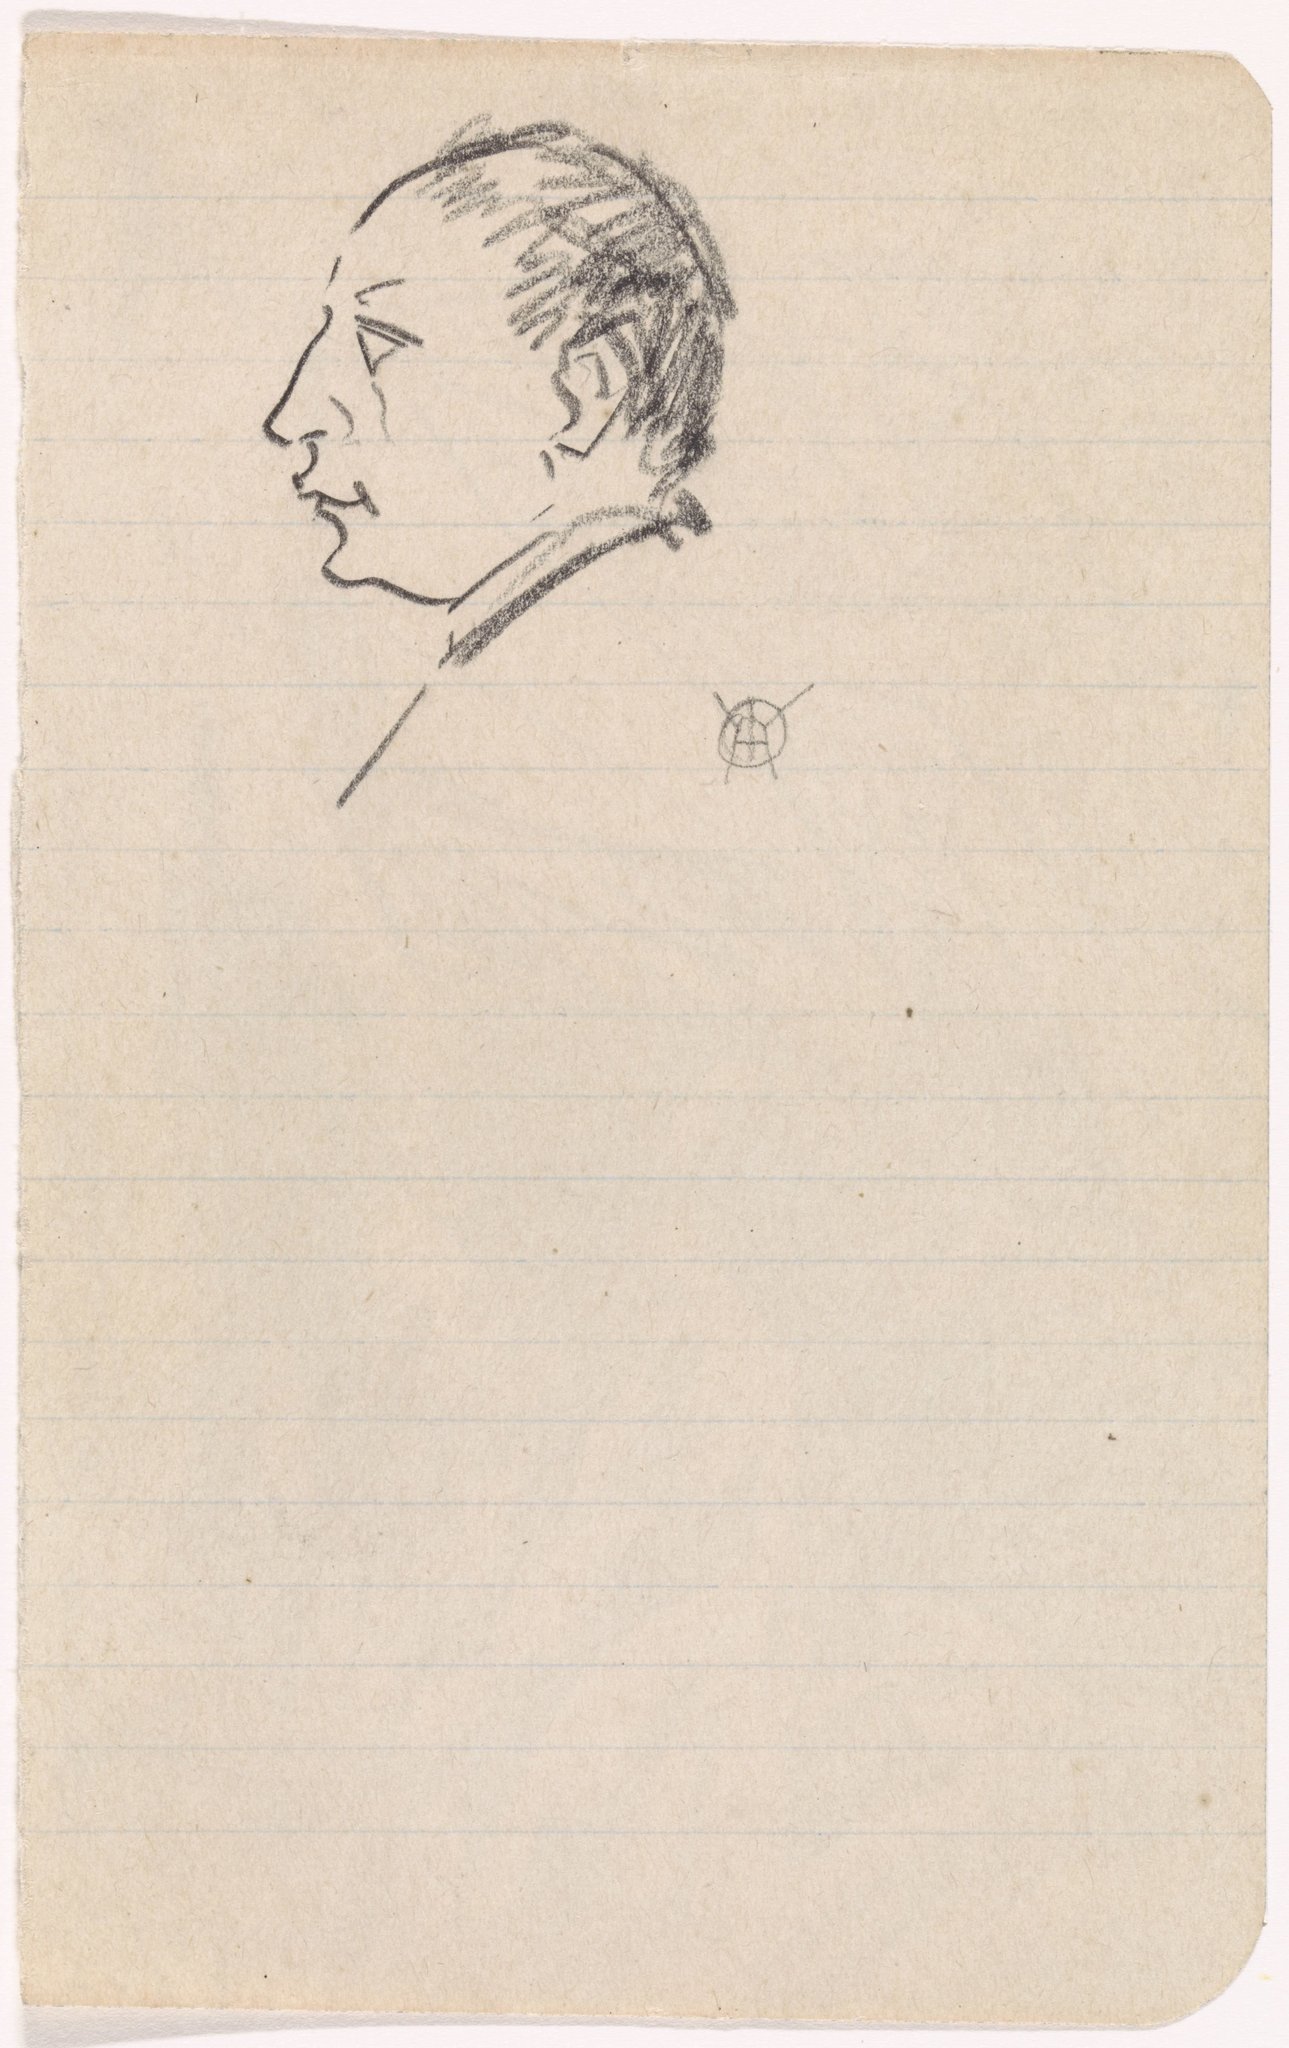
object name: drawing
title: Hoofd van een man, in profiel naar links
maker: gerrit willem dijsselhof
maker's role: designer, draughtsman, print maker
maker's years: 1866-1924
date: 1876-1924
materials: chalk, paper